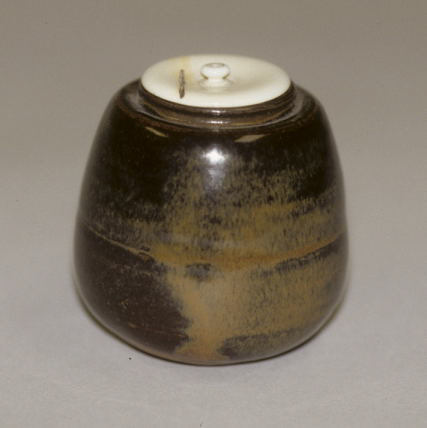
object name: tea caddy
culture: japanese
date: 1755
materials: glaze, iron, stoneware